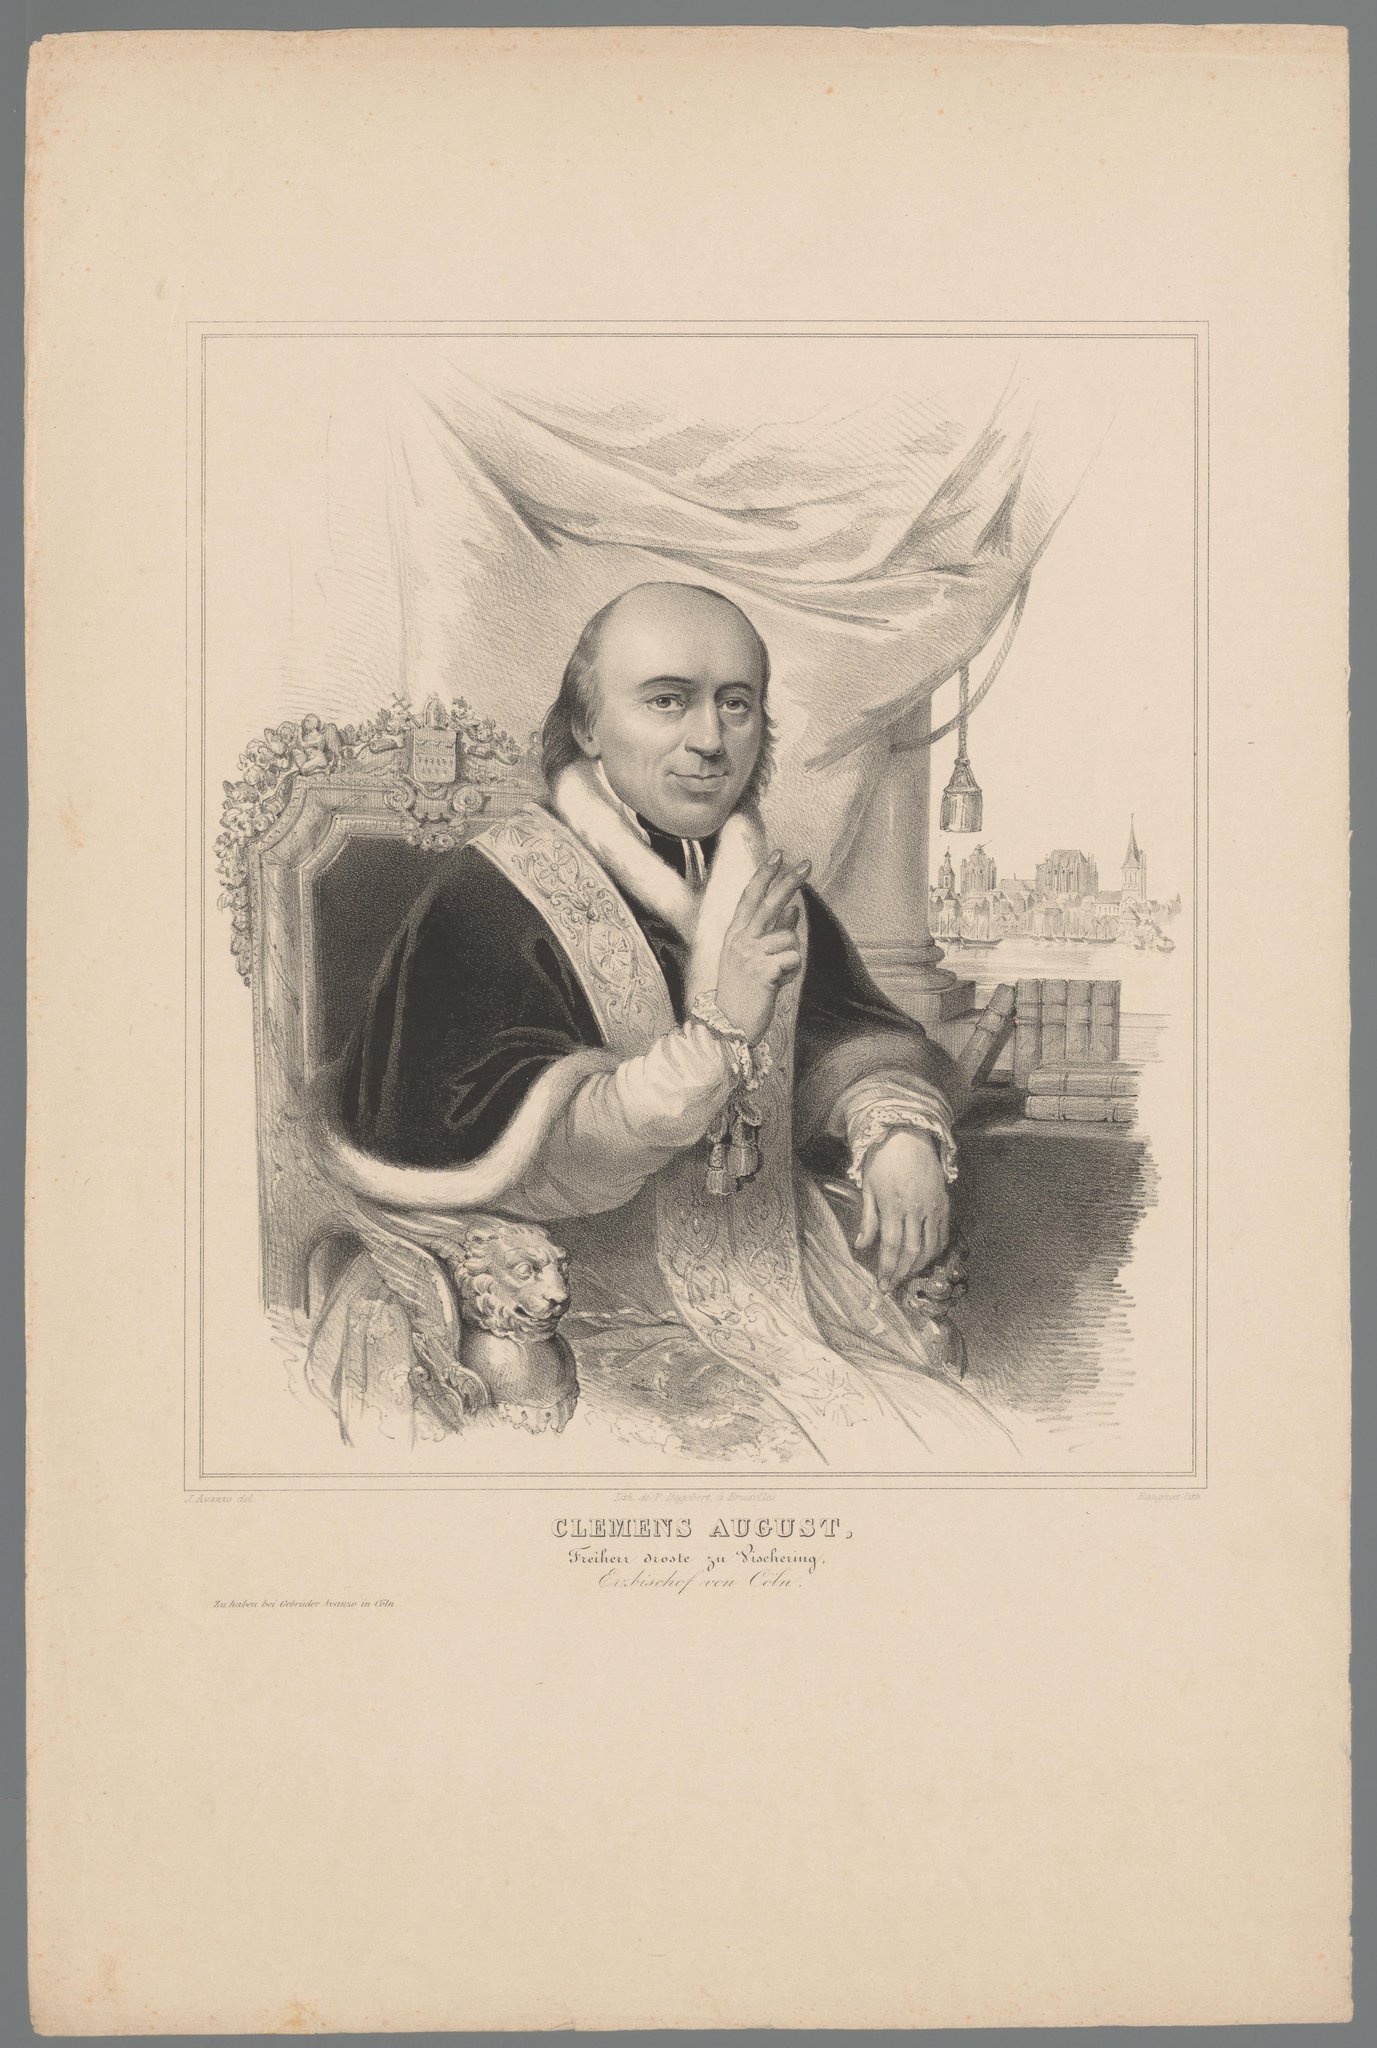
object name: print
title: Portret van Clemens August von Droste-Vischering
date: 1824-1844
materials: paper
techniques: lithograph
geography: cologne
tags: archbishop, bishop, etc. (roman catholic), historical persons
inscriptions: collector's mark: Lugt 2228